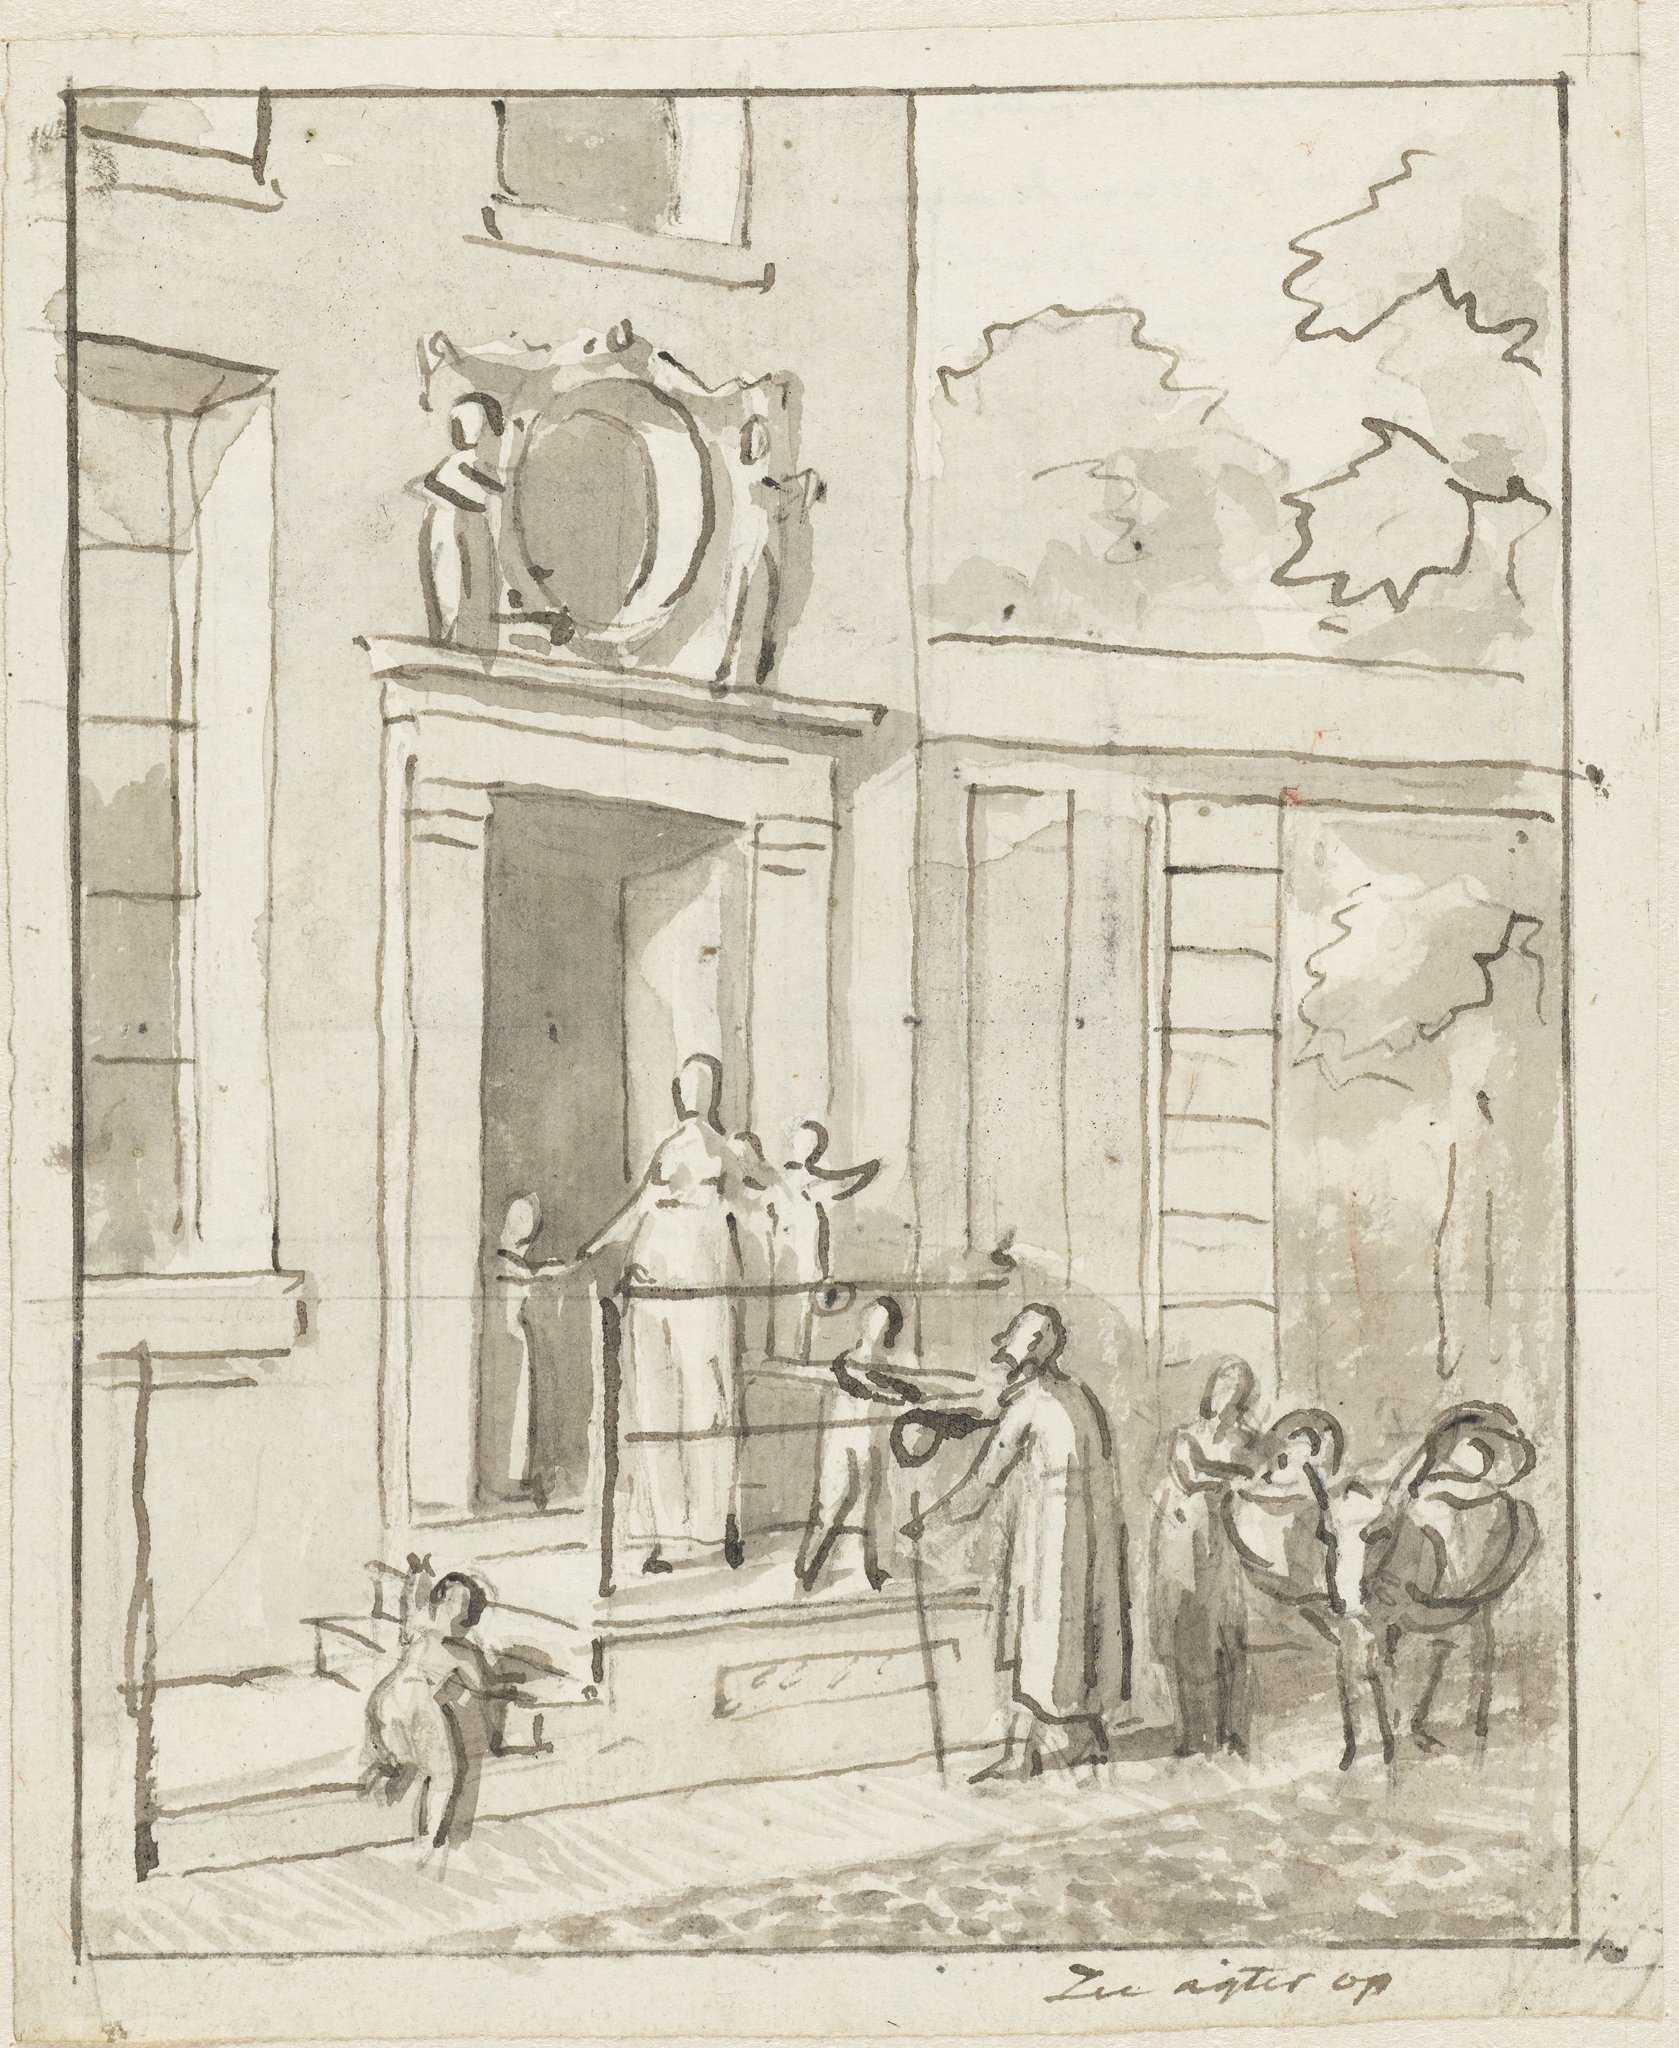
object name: drawing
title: Scène voor een huis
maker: jurriaan andriessen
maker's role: draughtsman, painter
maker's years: 1742-1819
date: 1752-1819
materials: graphite, ink, paper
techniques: brush, pen